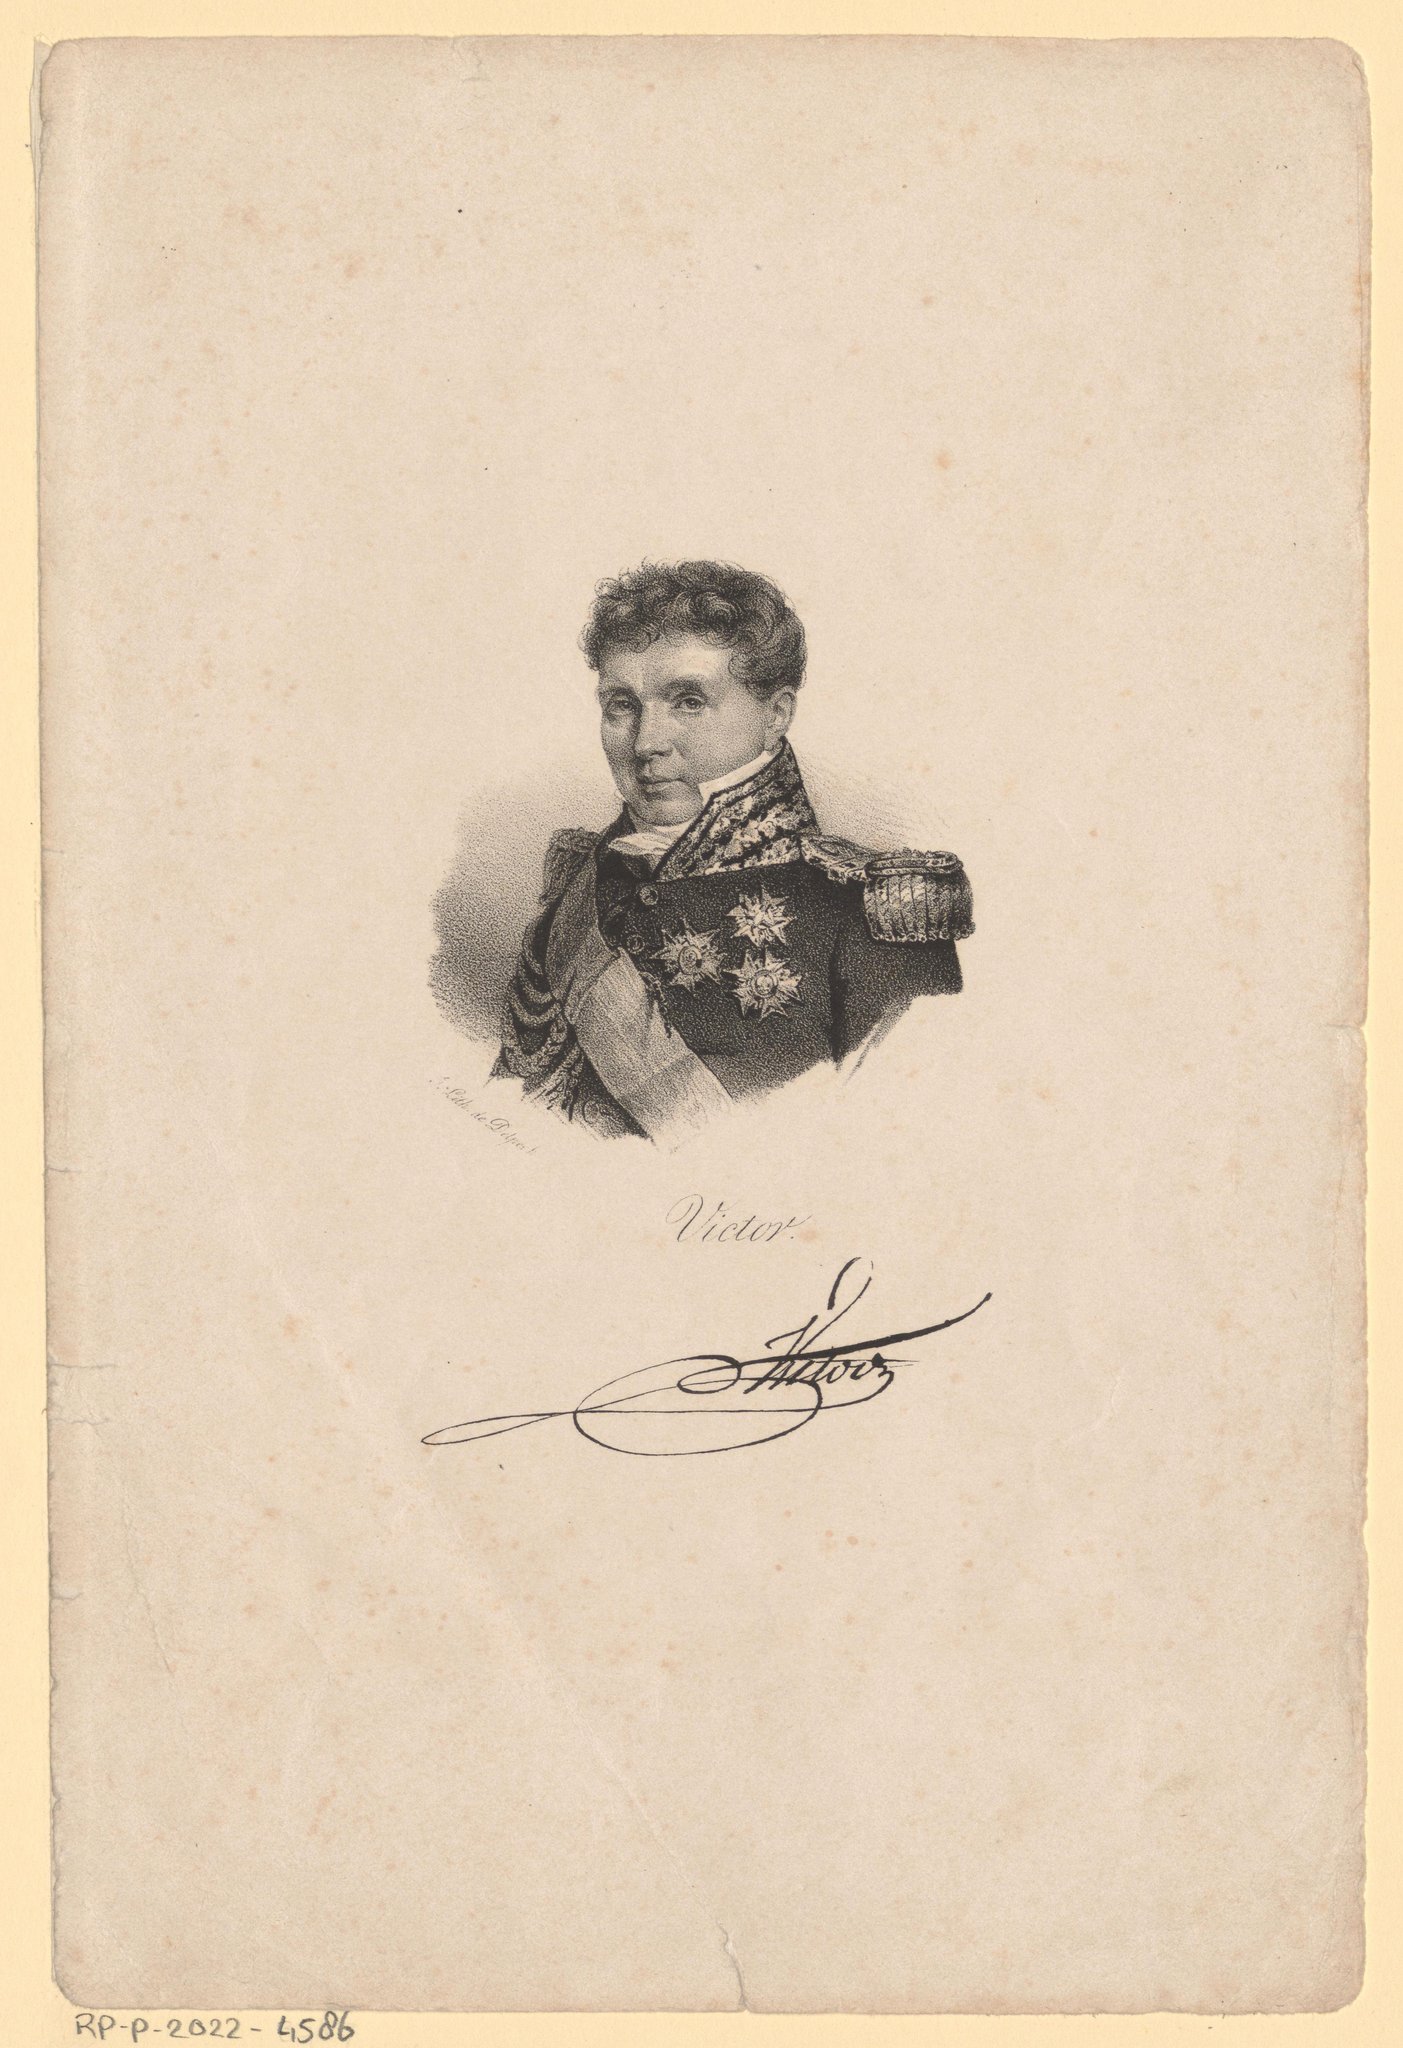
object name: print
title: Portret van Claude Victor-Perrin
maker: Anonymous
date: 1818-1842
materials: paper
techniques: lithograph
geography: france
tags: commander-in-chief, general, marshal, historical persons, medals and other marks of military honour